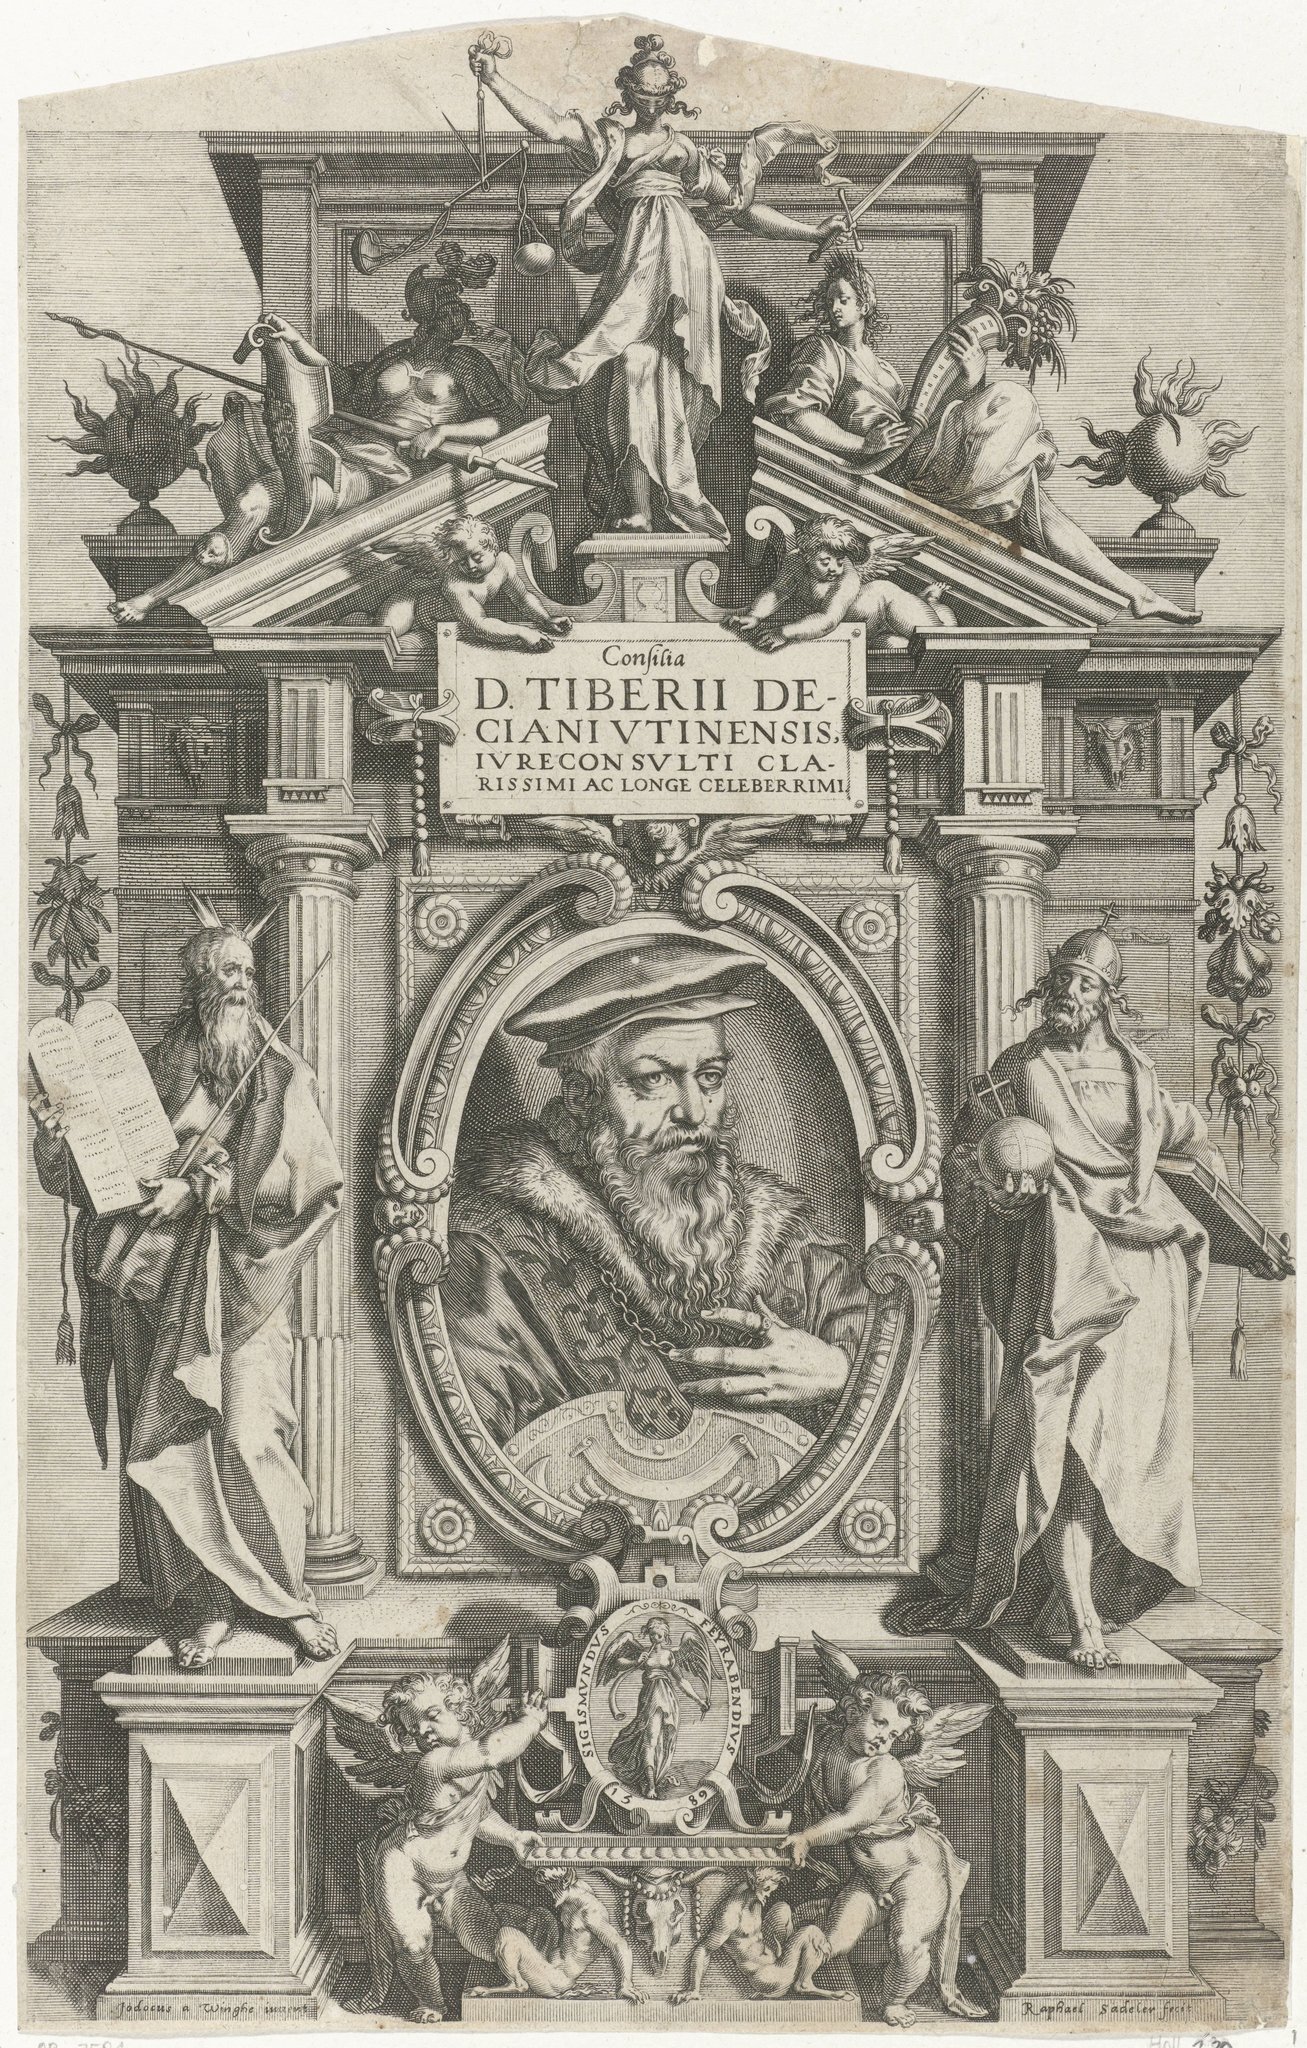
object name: book illustration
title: Titelpagina voor Tiberius Deciano, Consilia et responsa, 1589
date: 1589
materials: paper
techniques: engraving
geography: frankfurt am main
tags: (story of) ceres (demeter), justice, 'justitia'; 'giustitia divina' (ripa) ~ one of the four cardinal virtues, (story of) mars (ares), moses (not in biblical context); possible attributes: rays of light or horns on his head, rod, tables of the law, fame; 'fama', 'fama buona', 'fama chiara' (ripa)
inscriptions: collector's mark: Lugt 2228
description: In een architecturale omlijsting het portret van Tiberius Deciano, een jurist en schrijver uit Padua. Het portret wordt geflankeerd door Mozes (links) en Christus (?) (rechts). Op het fronton van de architecturale omlijsting de personificatie Rechtvaardigheid, met zwaard en weegschaal. Links ligt de god Mars, rechts ligt de godin Ceres. Onder het portret houden twee putti een medaillon vast met daarin de personificatie Fama.